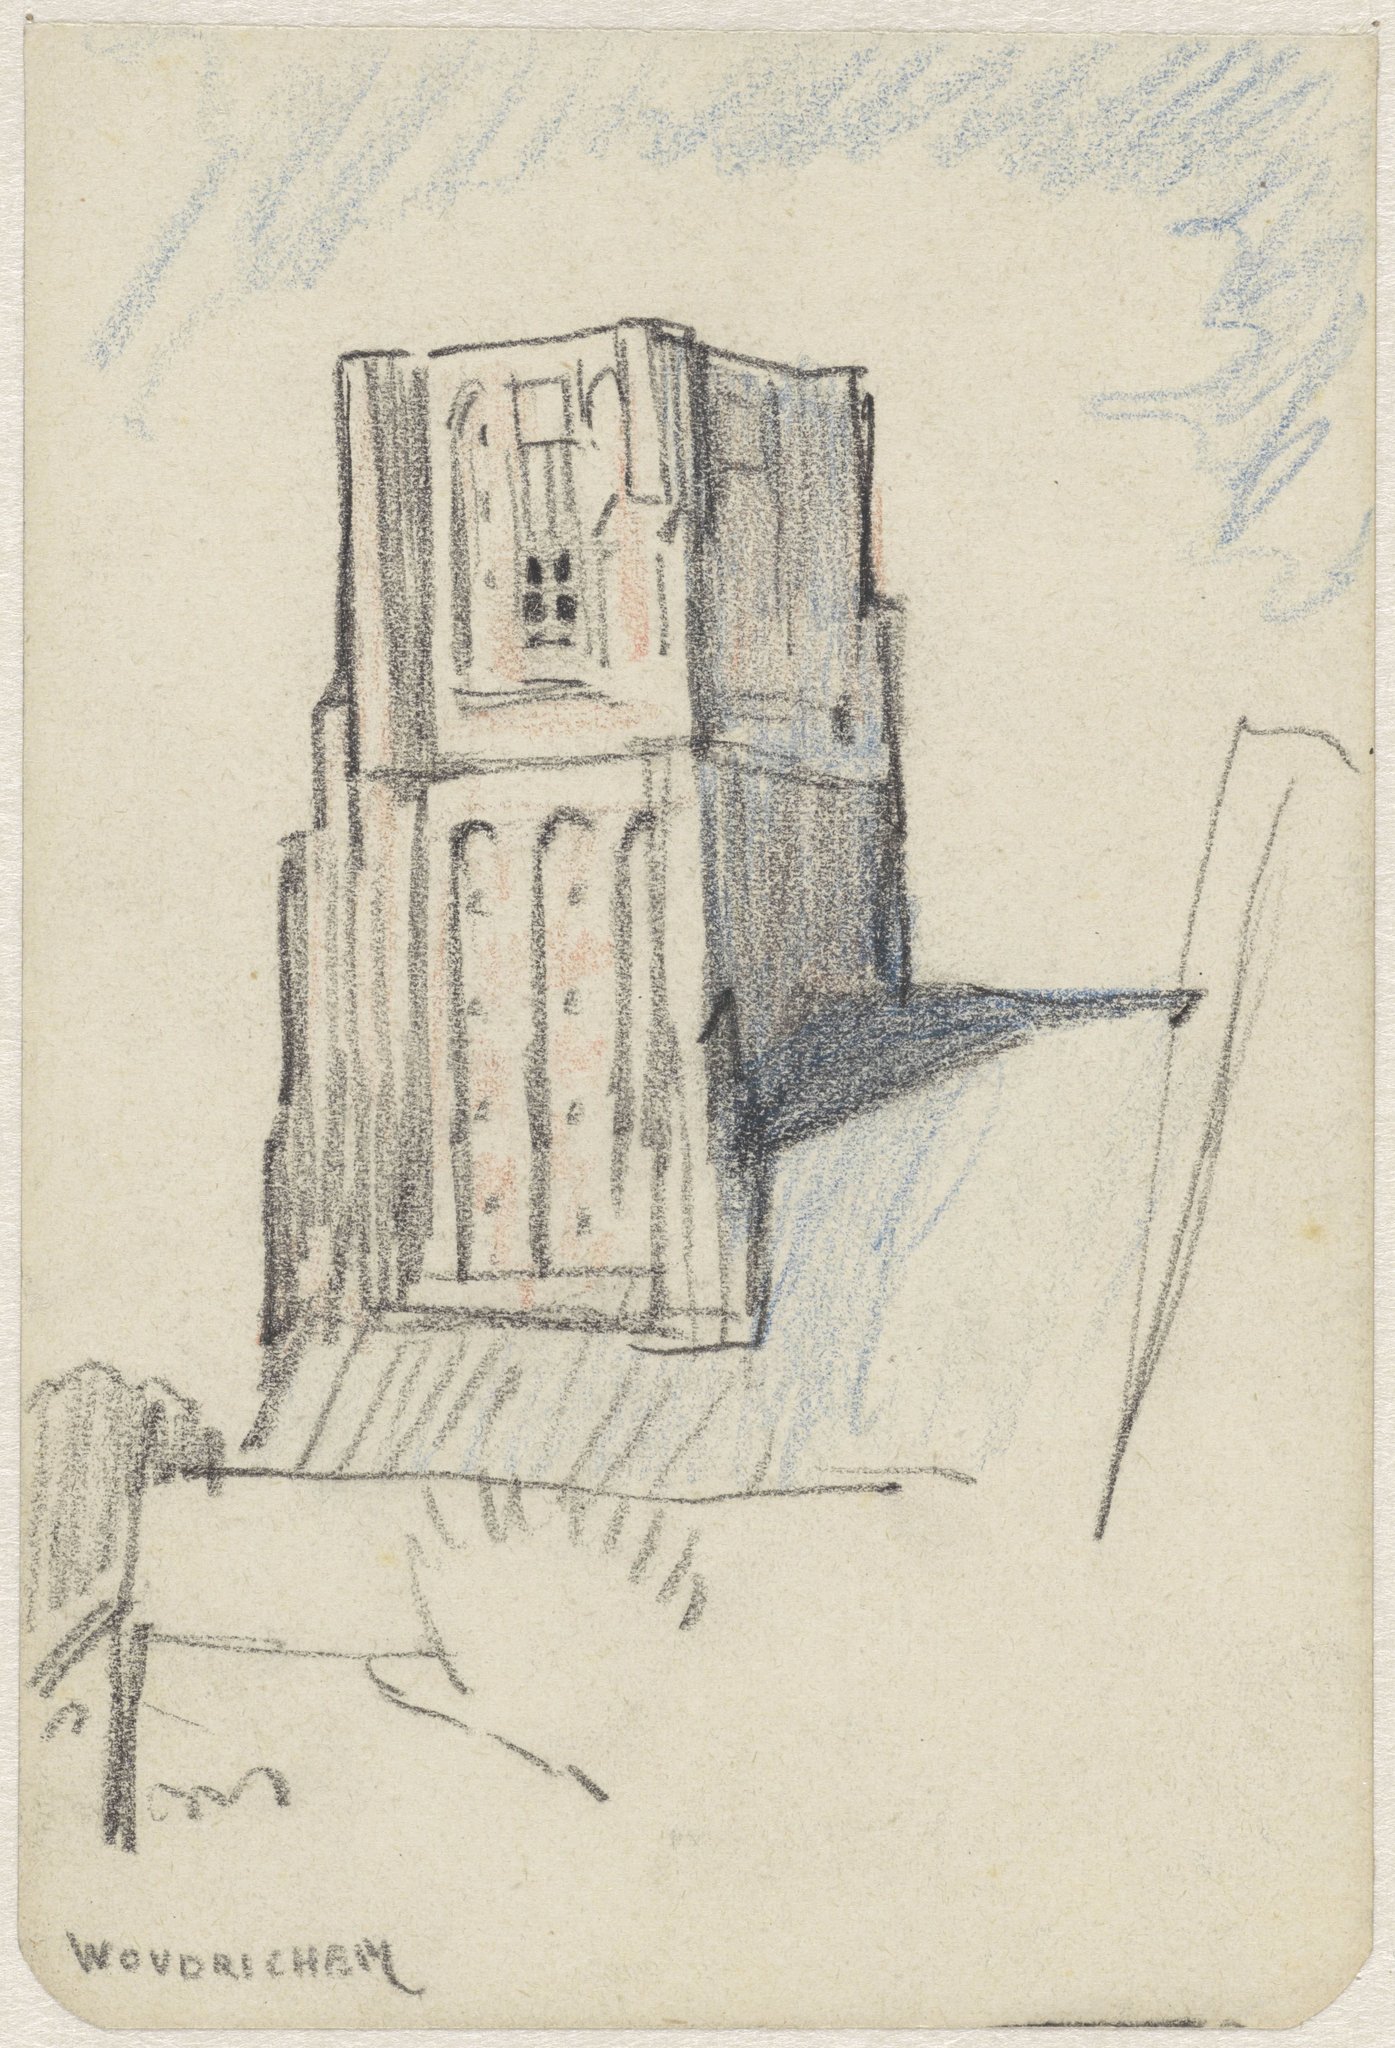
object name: drawing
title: Kerktoren te Woudrichem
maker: adolf le comte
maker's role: draughtsman, painter, print maker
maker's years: 1850-1921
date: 1860-1921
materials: chalk, paper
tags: church (exterior), woudrichem